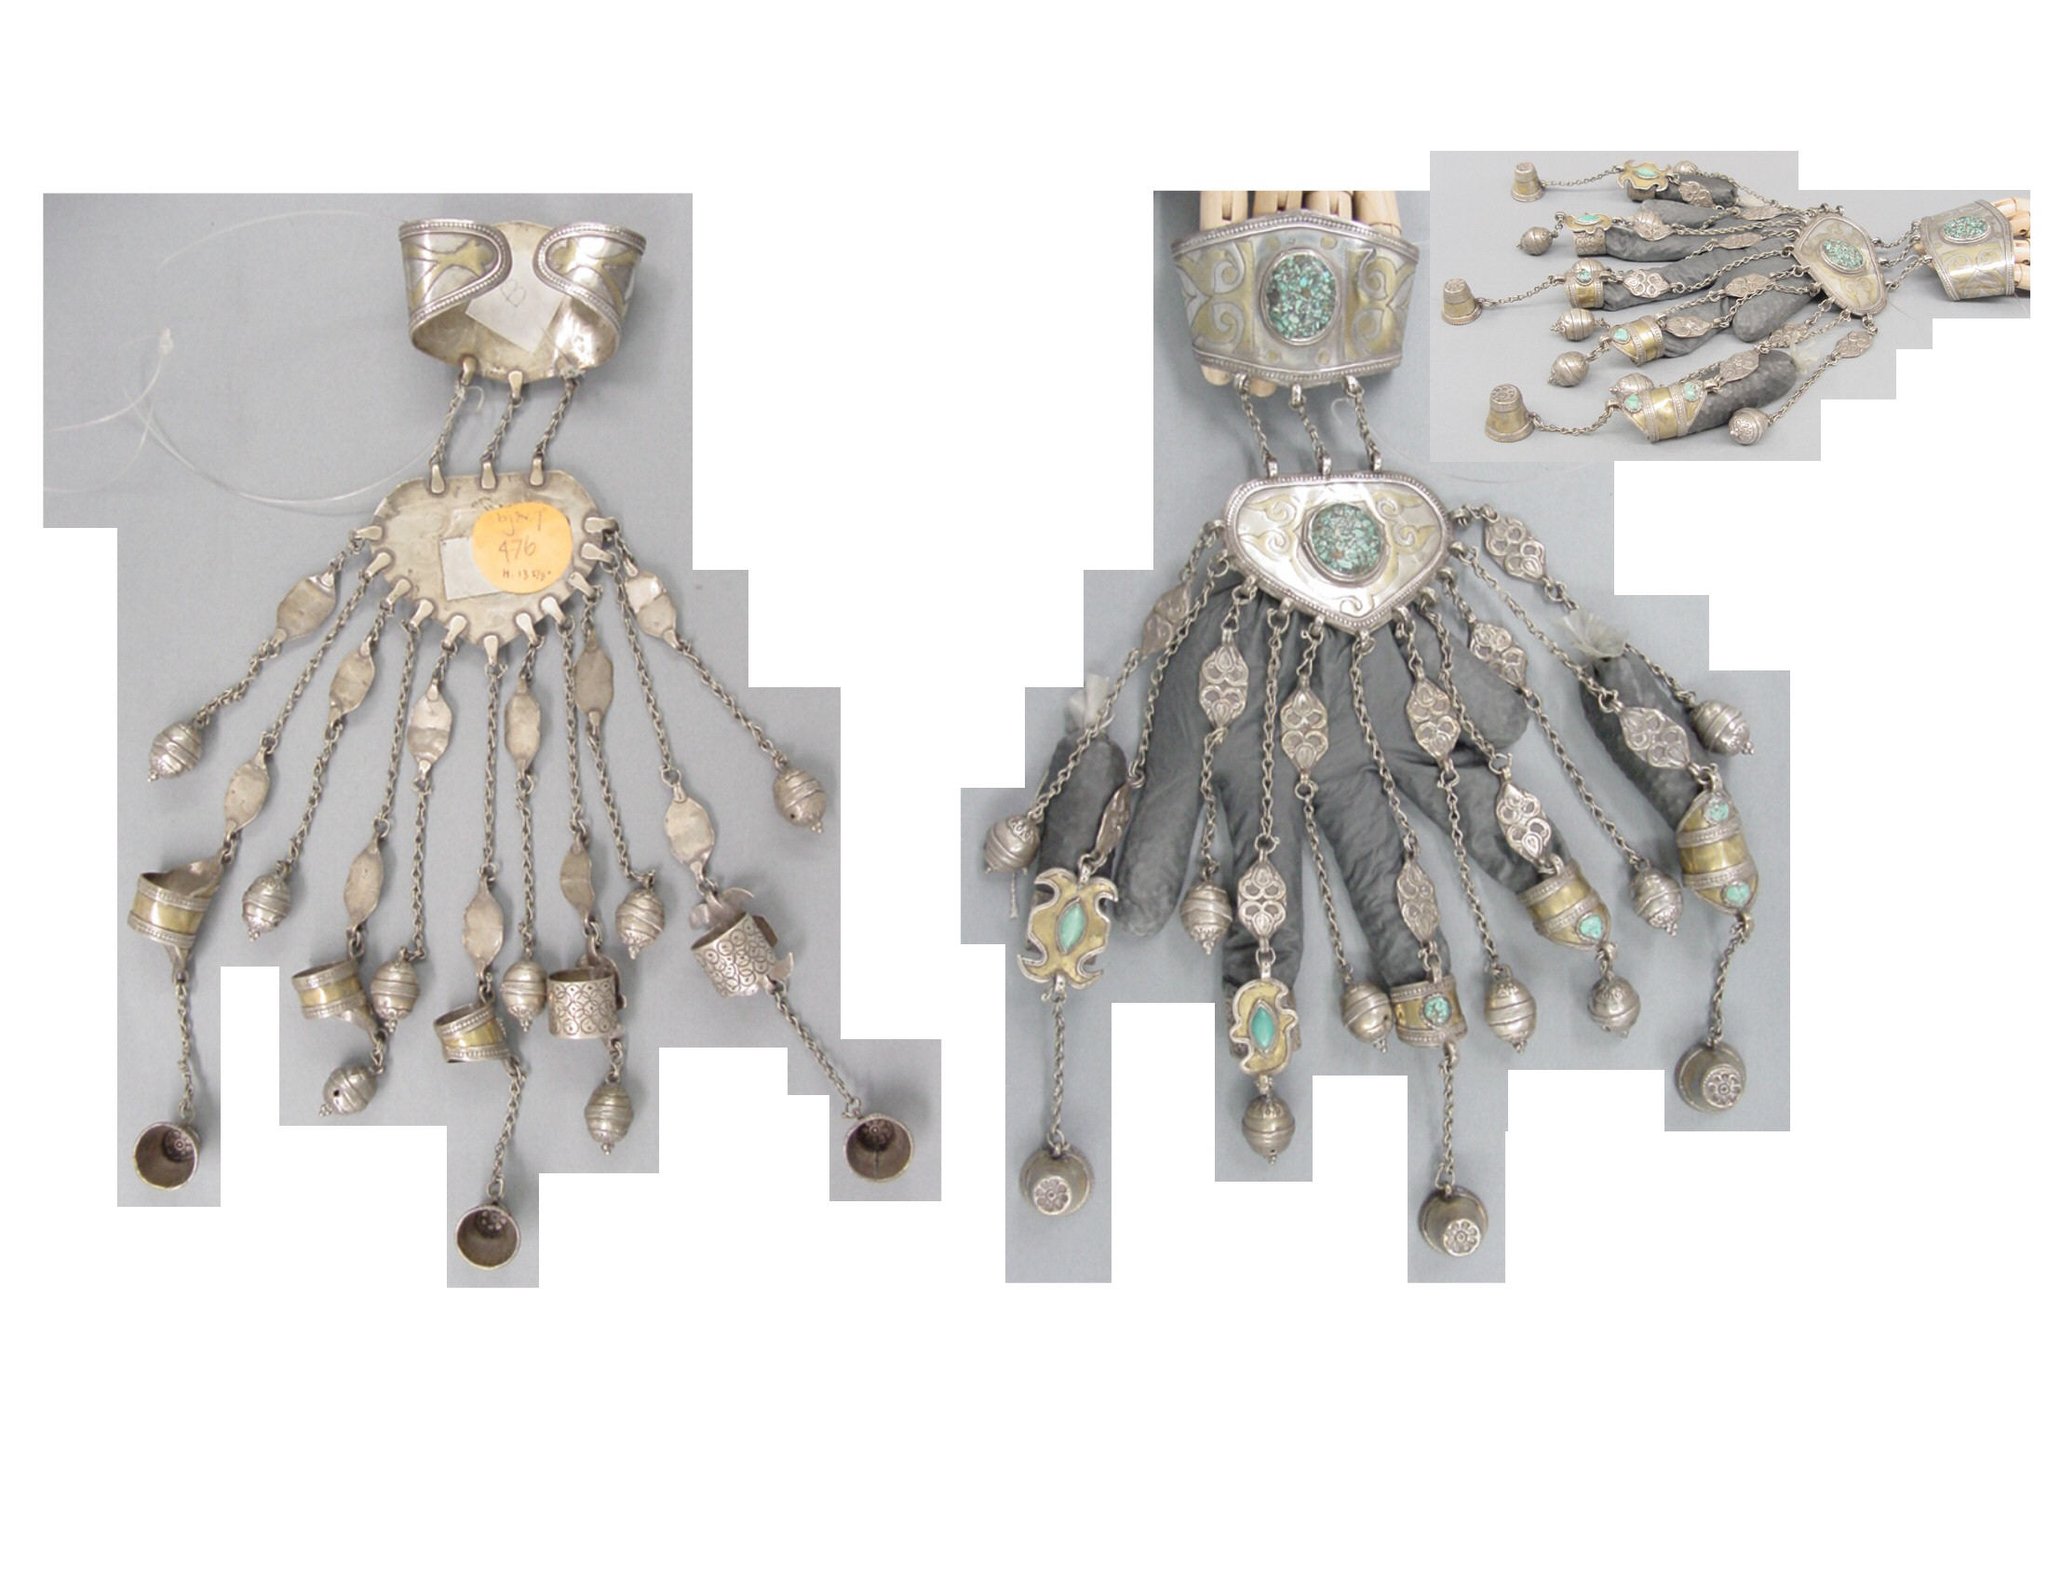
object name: armband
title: Armband with Bells, Rings, and Thimbles, One of a Pair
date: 1867-1900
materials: silver, metal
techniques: chasing, gilding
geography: central asia or northern afghanistan